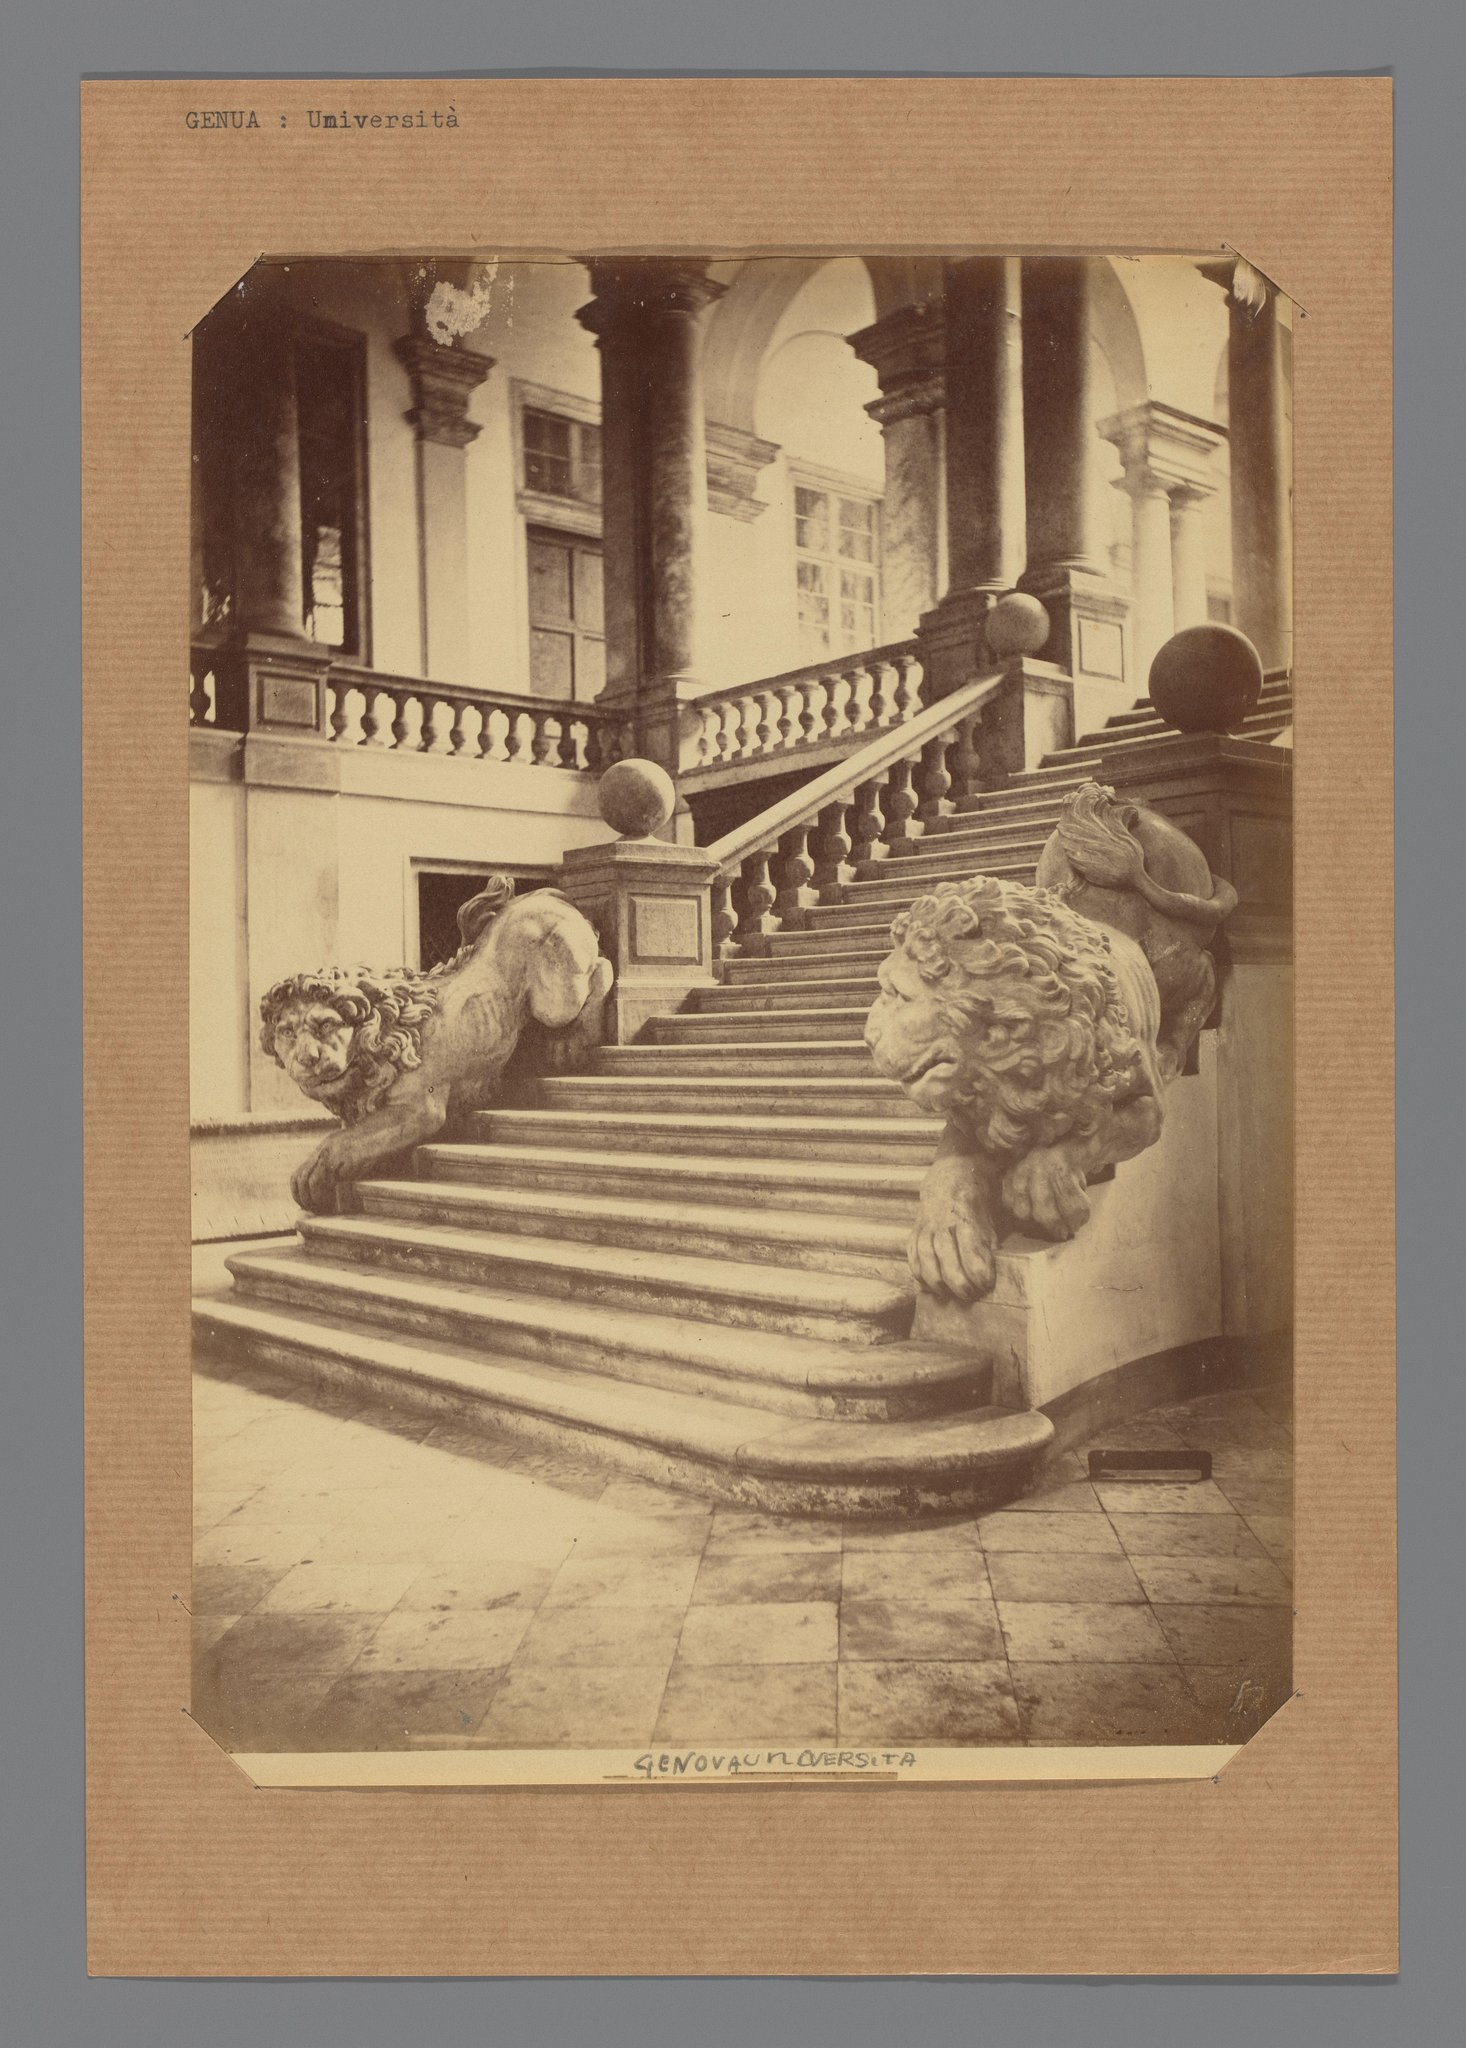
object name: photograph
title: Italië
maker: Anonymous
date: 1880-1910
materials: photographic support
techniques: albumen print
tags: italy